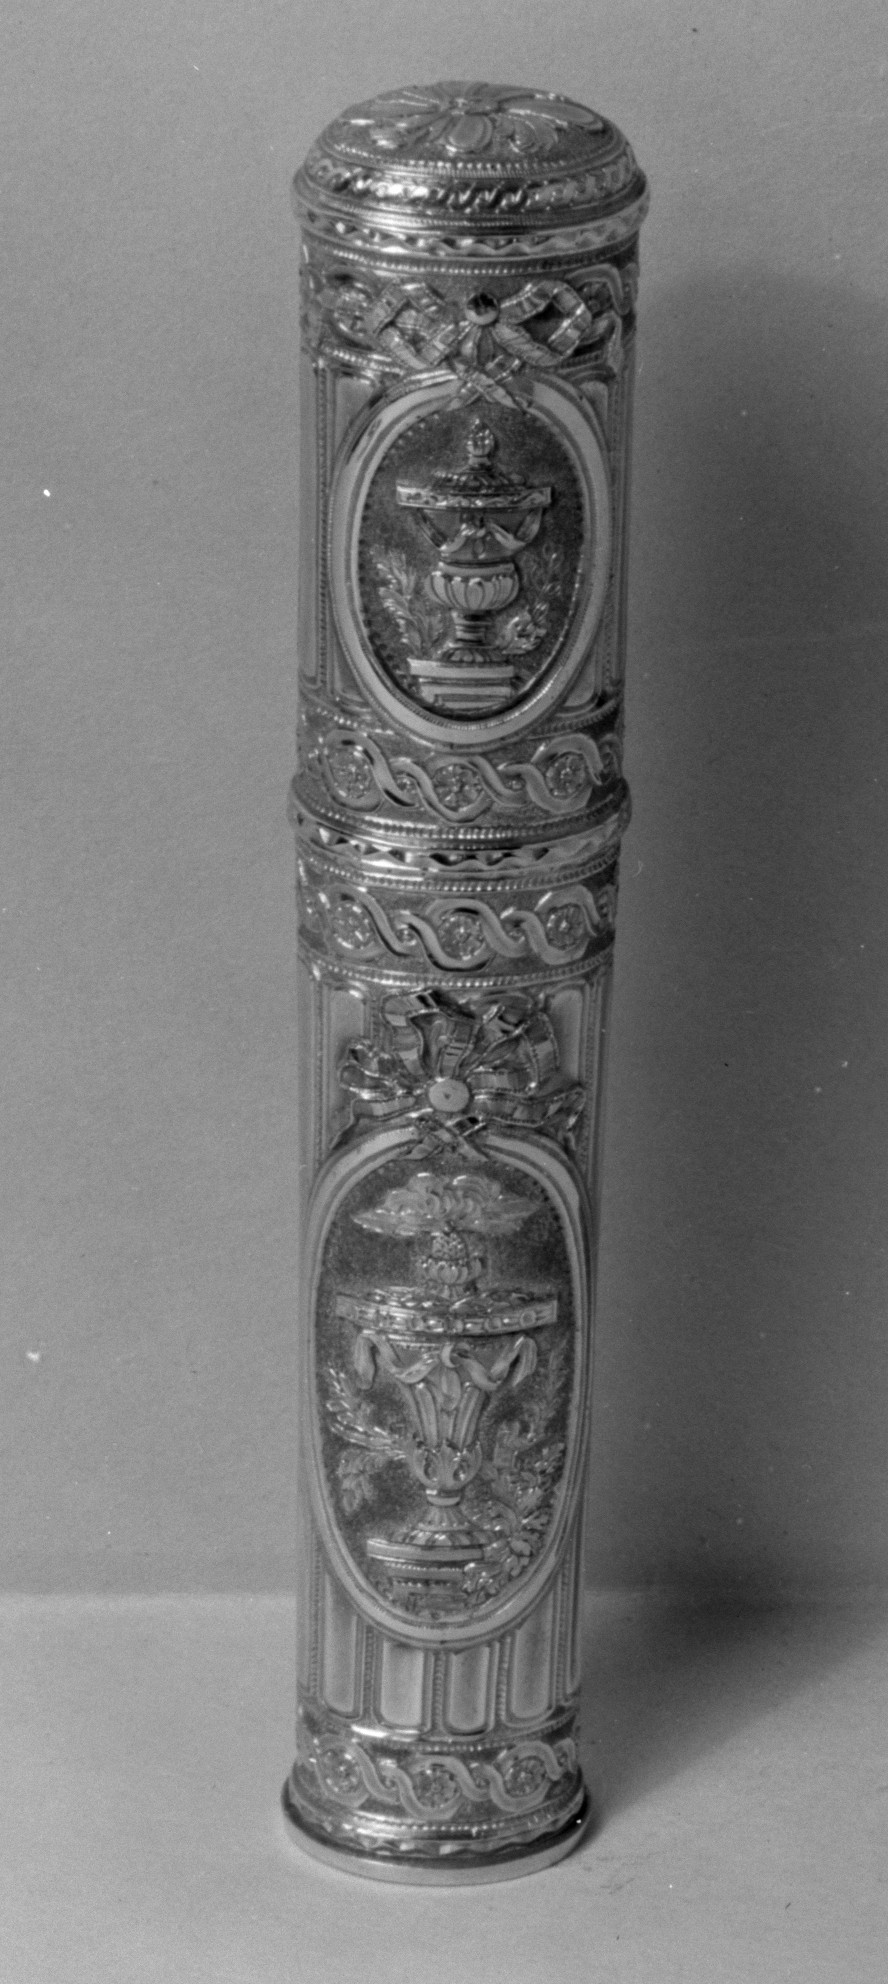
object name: étui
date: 1764-1765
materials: gold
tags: flowers